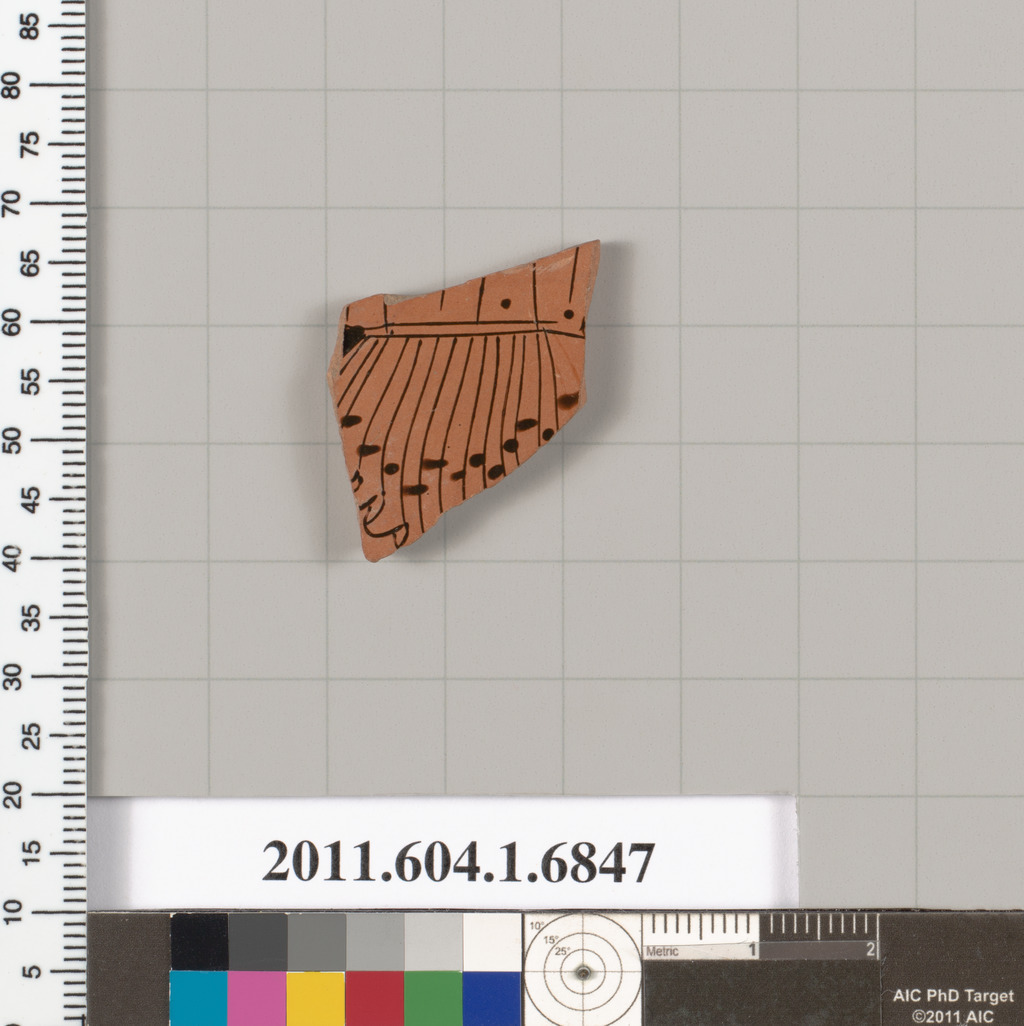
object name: kylix fragment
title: Terracotta fragment of a kylix (drinking cup)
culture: greek, attic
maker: painter of the paris gigantomachy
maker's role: artist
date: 490-480 BCE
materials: terracotta